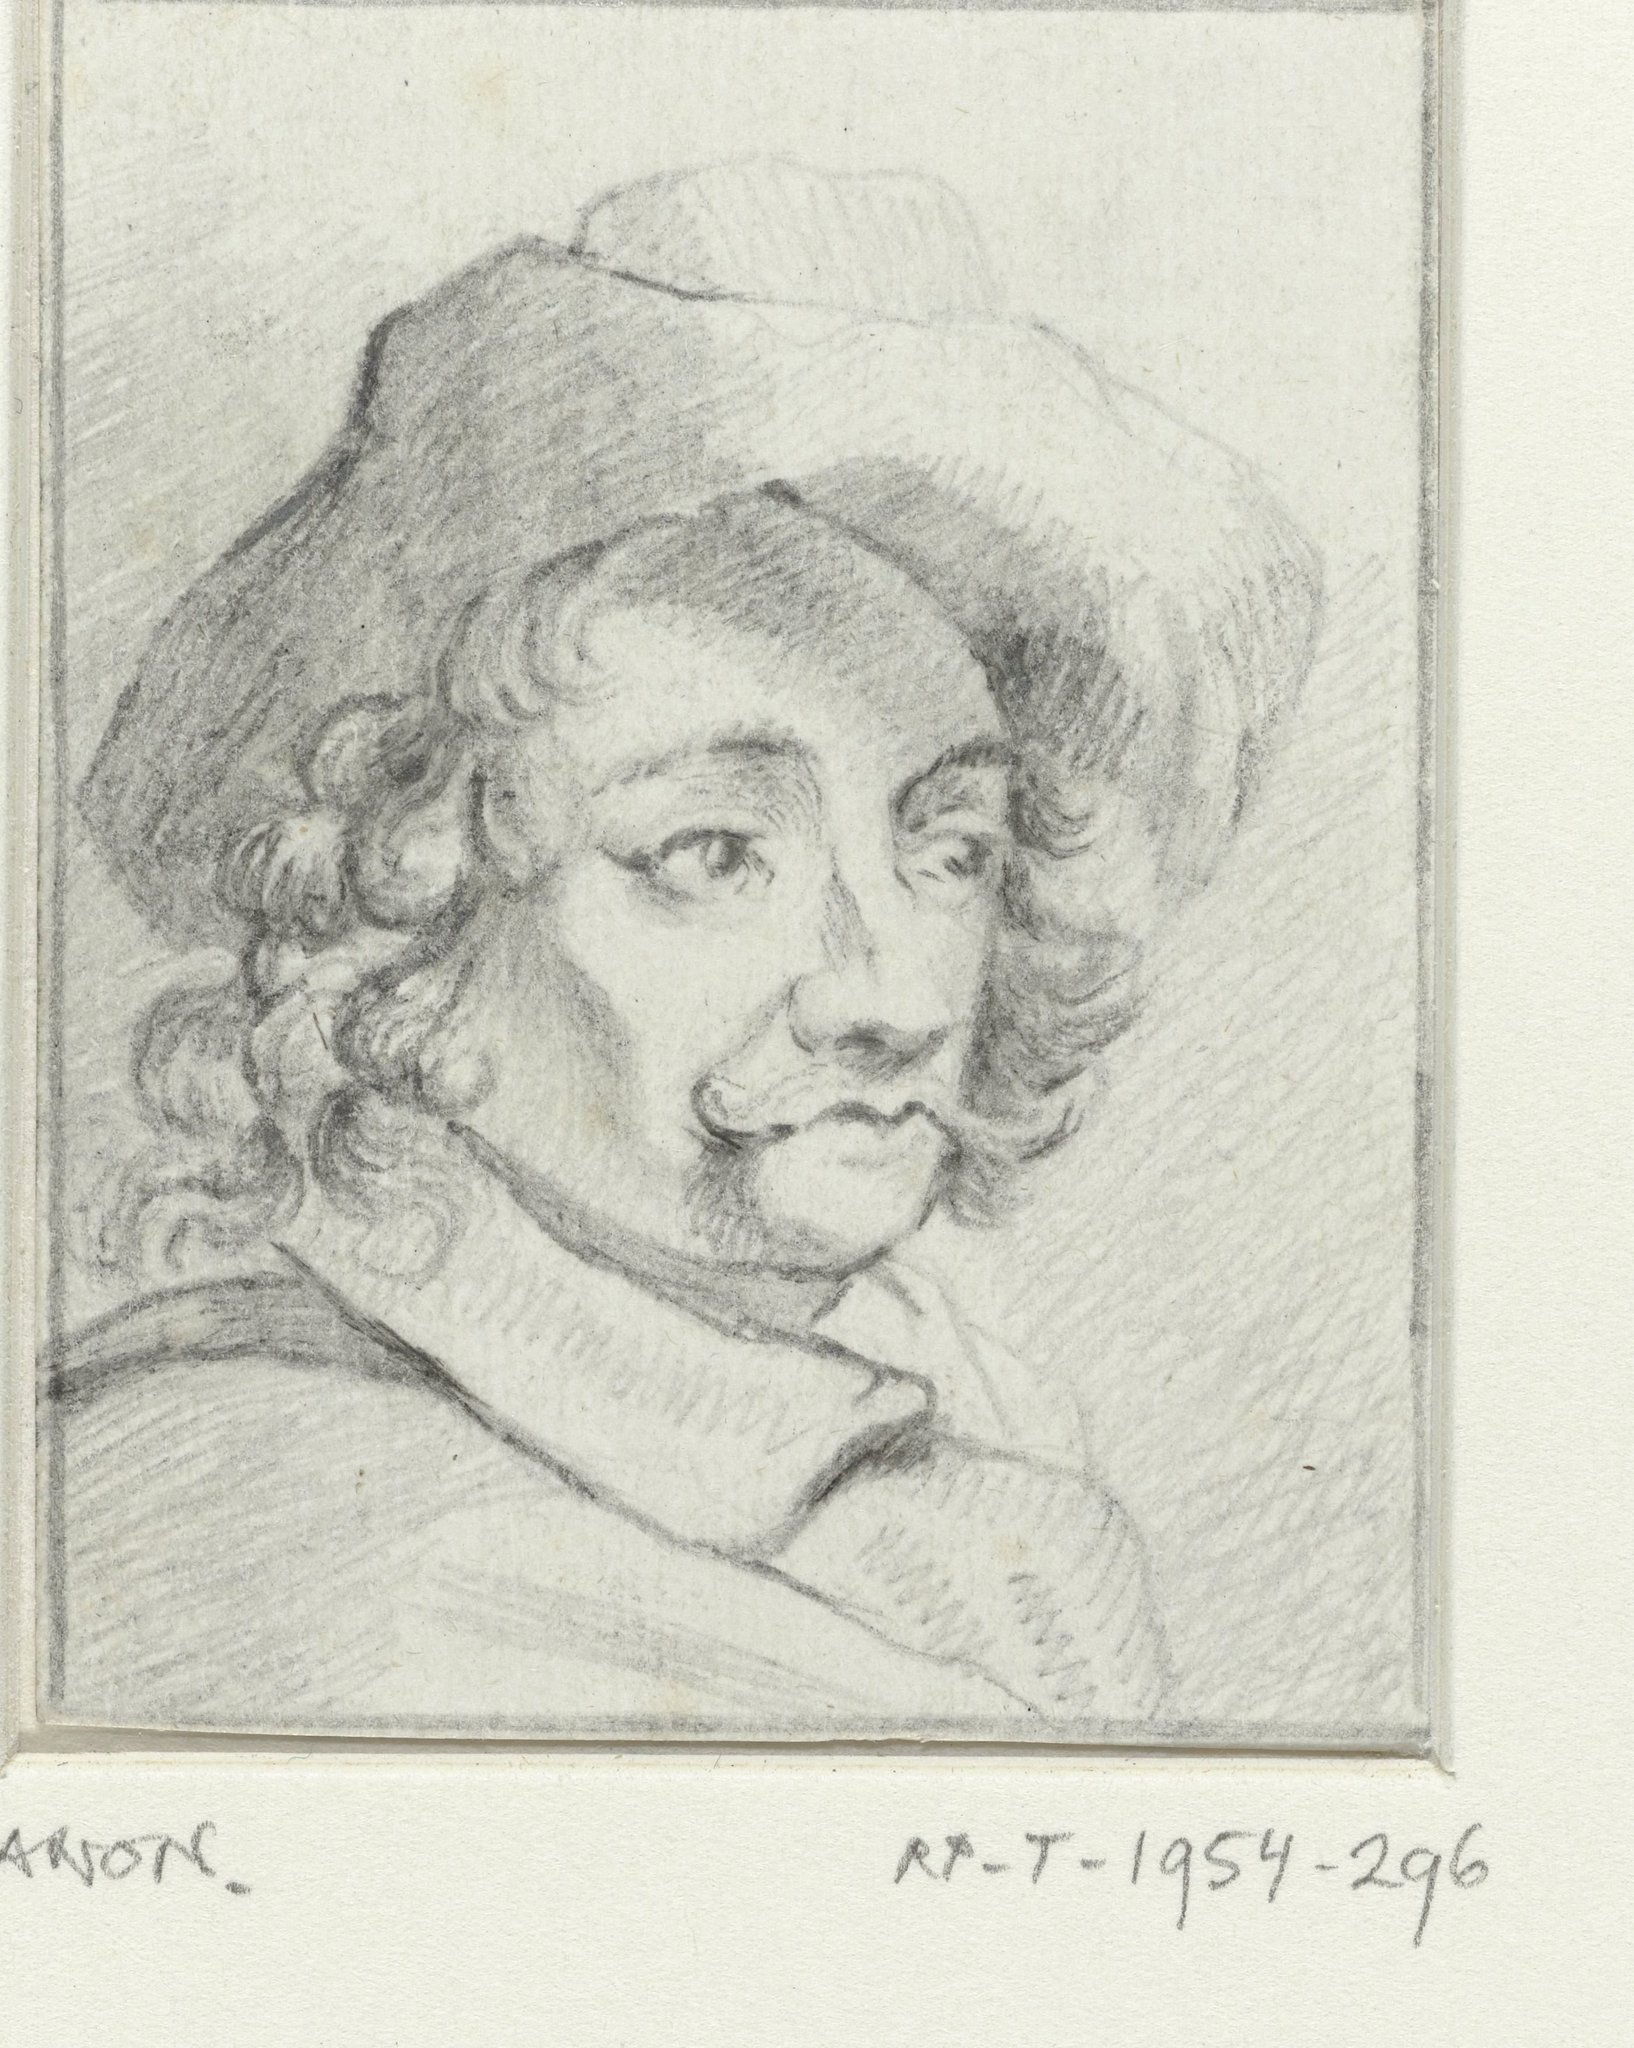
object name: playing card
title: Portret van de schilder Hendrik Verschuring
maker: Anonymous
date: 1700-1800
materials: paper, pencil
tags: dordrecht, print maker, draughtsman, hendrik verschuring, historical persons, portrait, self-portrait of painter, portrait, self-portrait of artist